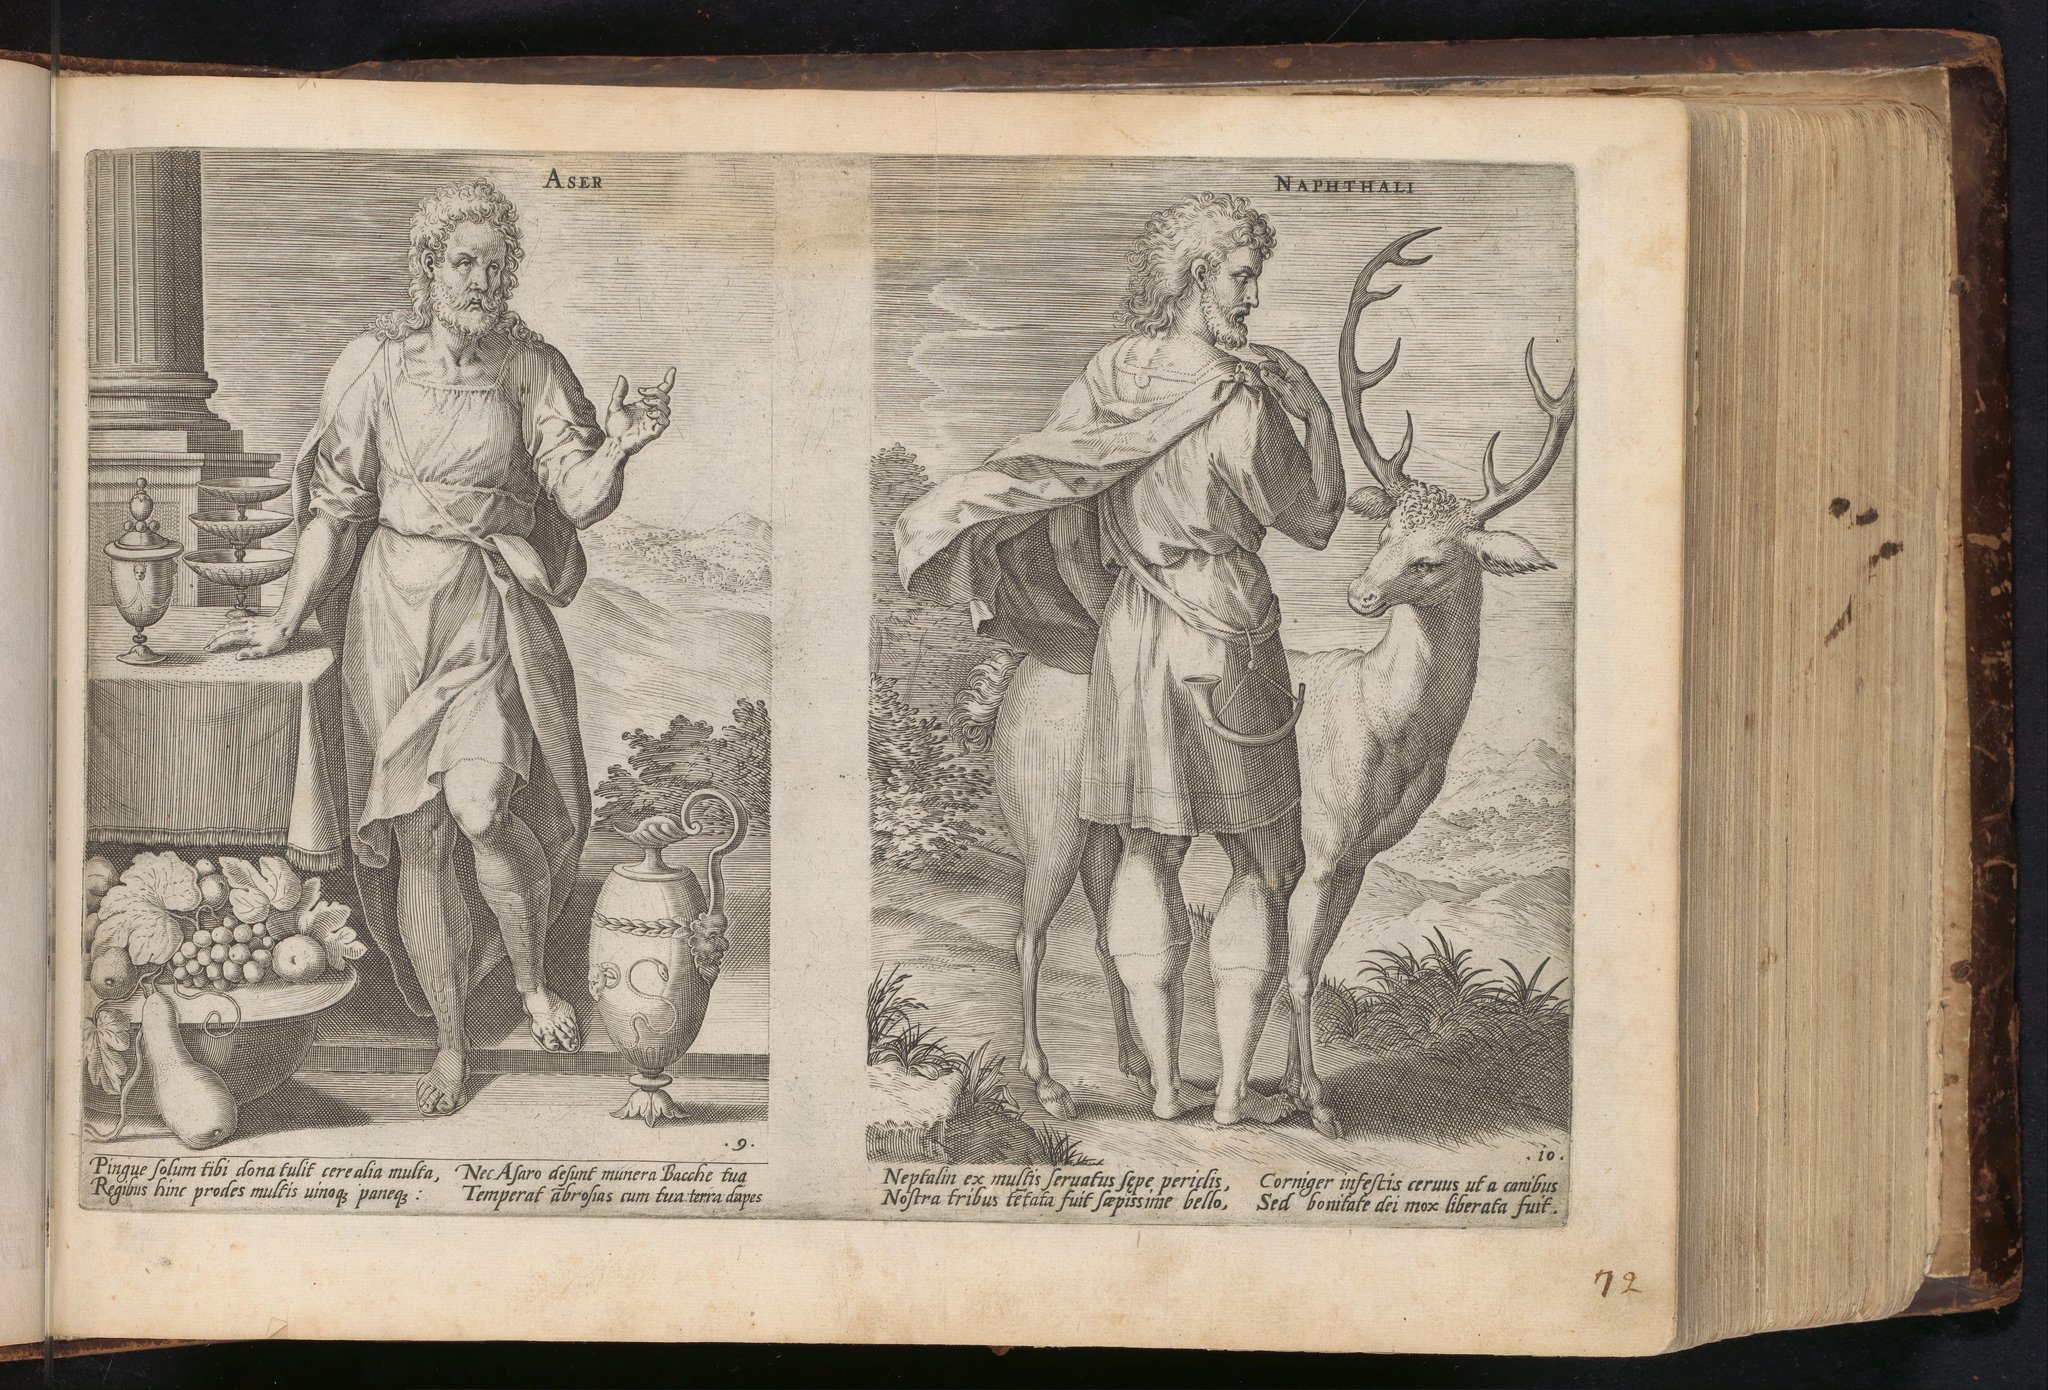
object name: album leaf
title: Den Grooten Figuer-Bibel (...)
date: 1585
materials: paper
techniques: engraving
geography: amsterdam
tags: 11i611(naphtali), 11i611(aser)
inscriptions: number: ‘72’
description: Links stamvader Aser, de achtste zoon van Jakob. Op de grond naast hem een schaal met vruchten en een kruik. Rechts stamvader Naftali, de zesde zoon van Jakob. Naast hem een hert. Onder de voorstellingen een verwijzing in het Latijn naar de Bijbeltekst. Deze prent maakt deel uit van een album.